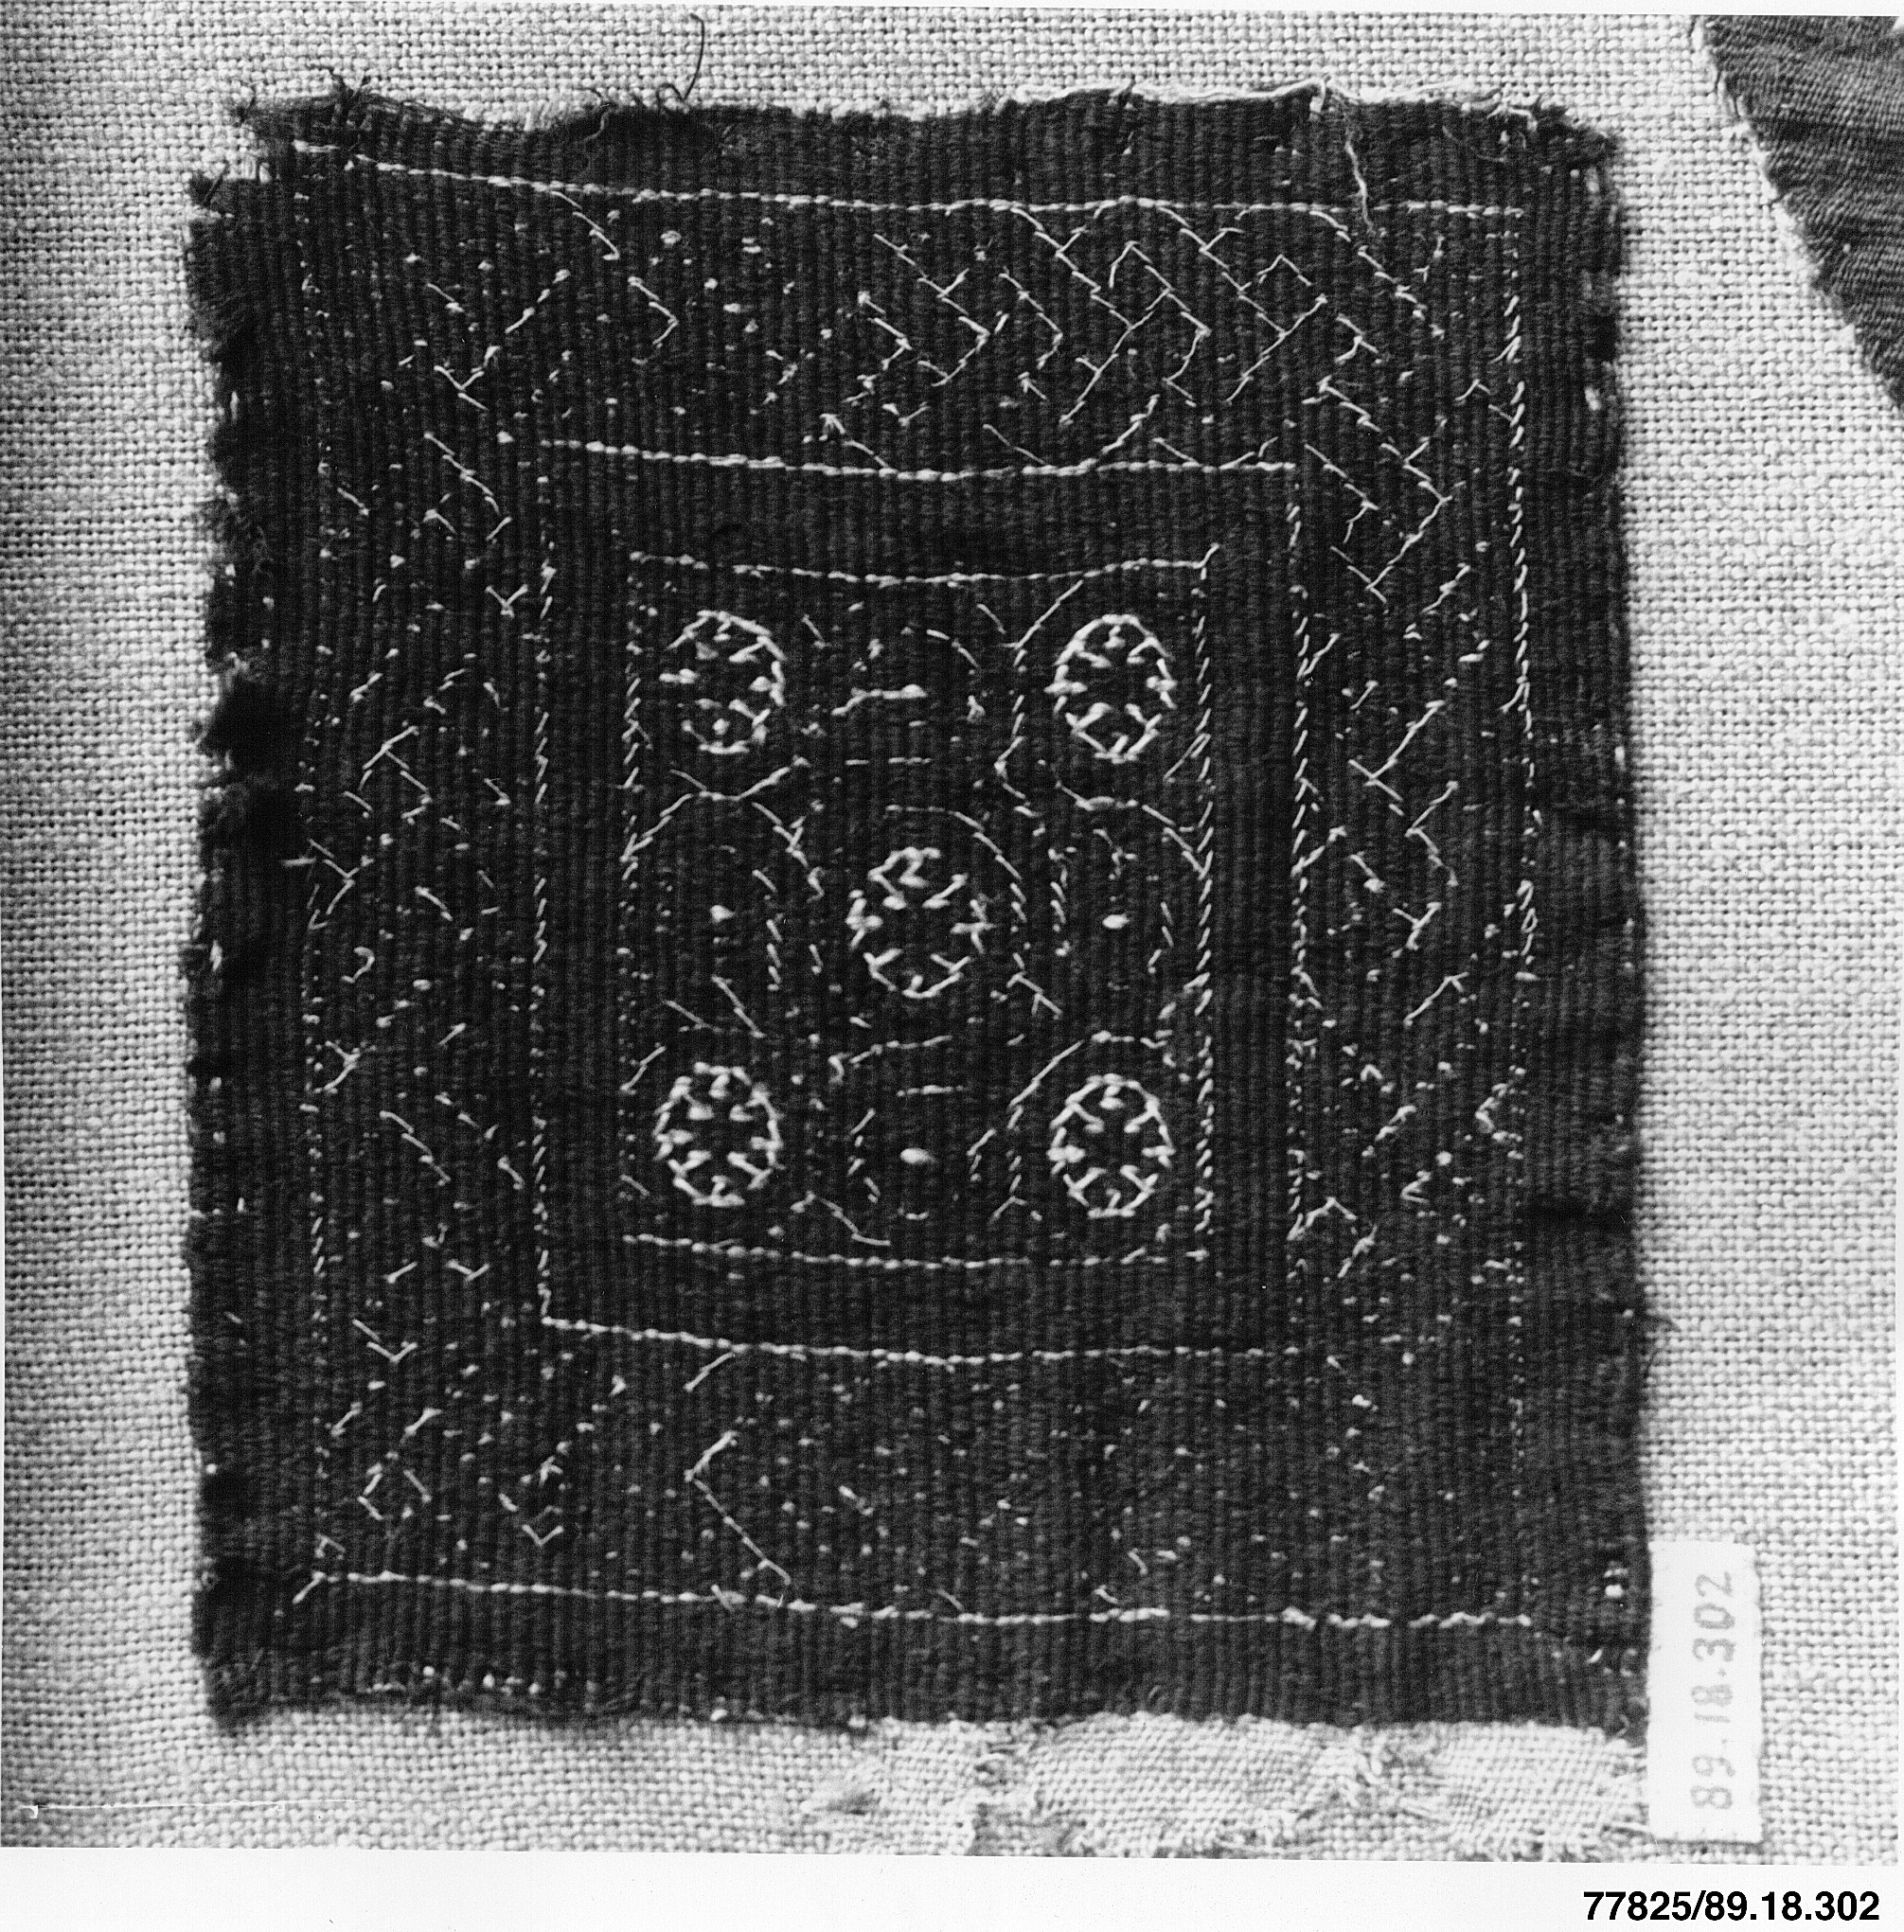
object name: textile fragment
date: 201-400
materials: linen, wool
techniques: weave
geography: egypt